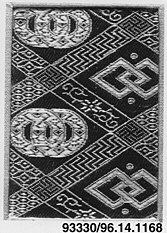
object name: piece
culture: japanese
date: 1701-1900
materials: silk